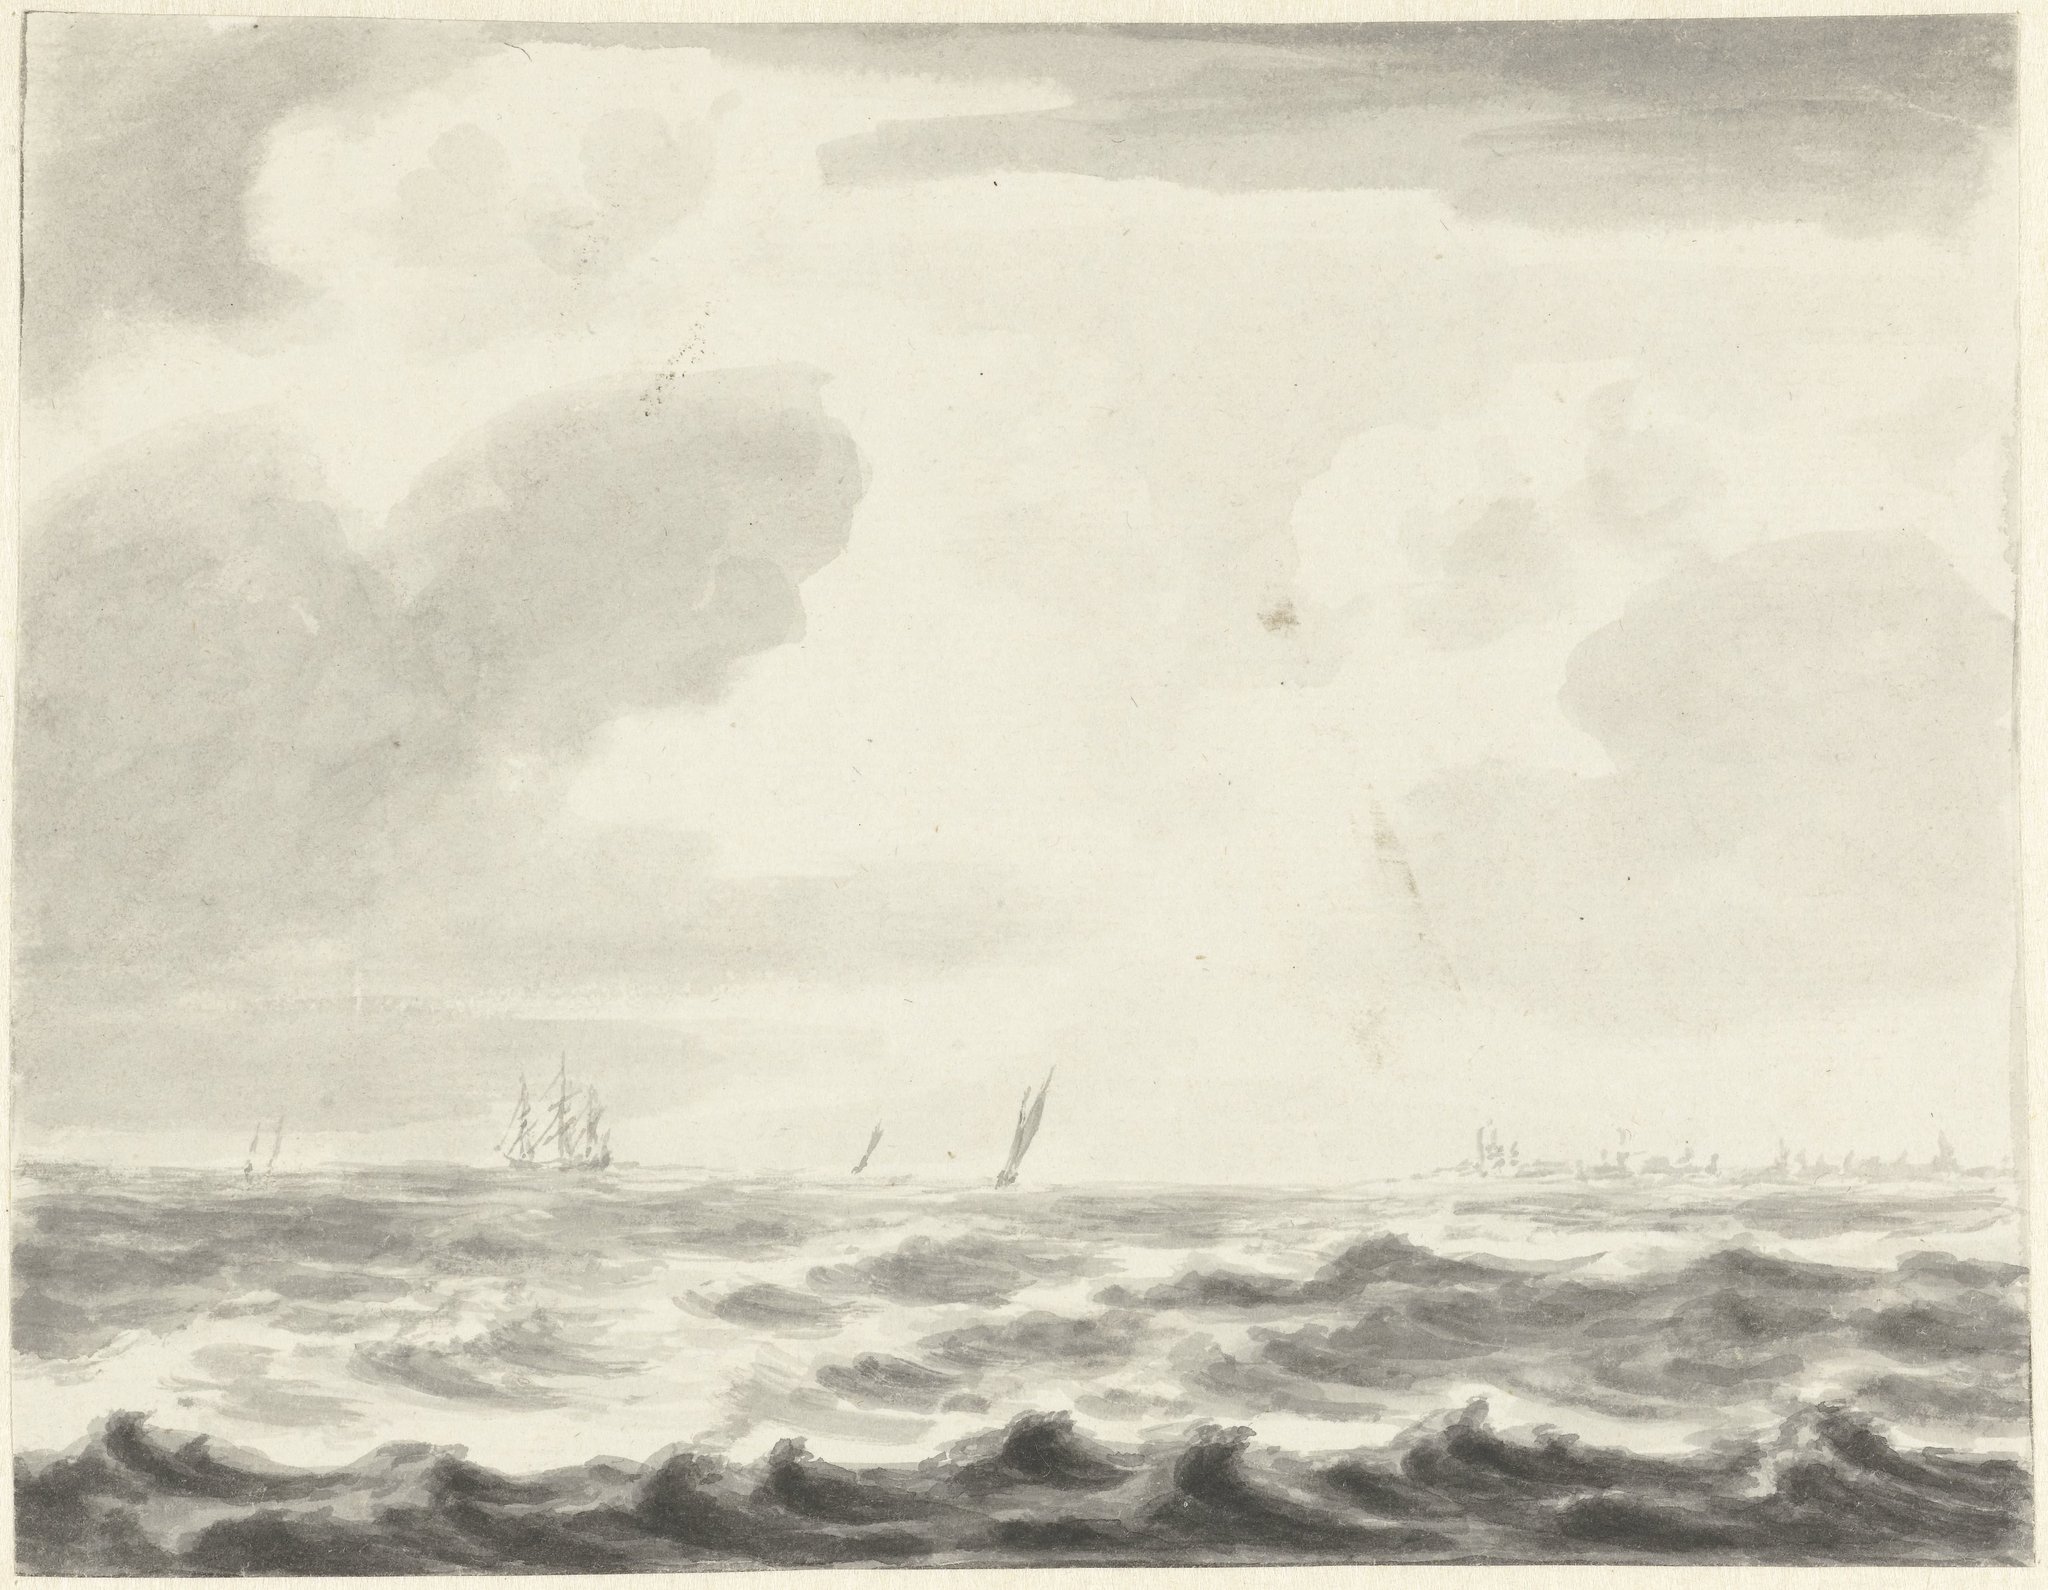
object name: drawing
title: Zeegezicht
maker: pieter idserts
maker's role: draughtsman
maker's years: 1698-1781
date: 1708-1781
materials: paper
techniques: brush